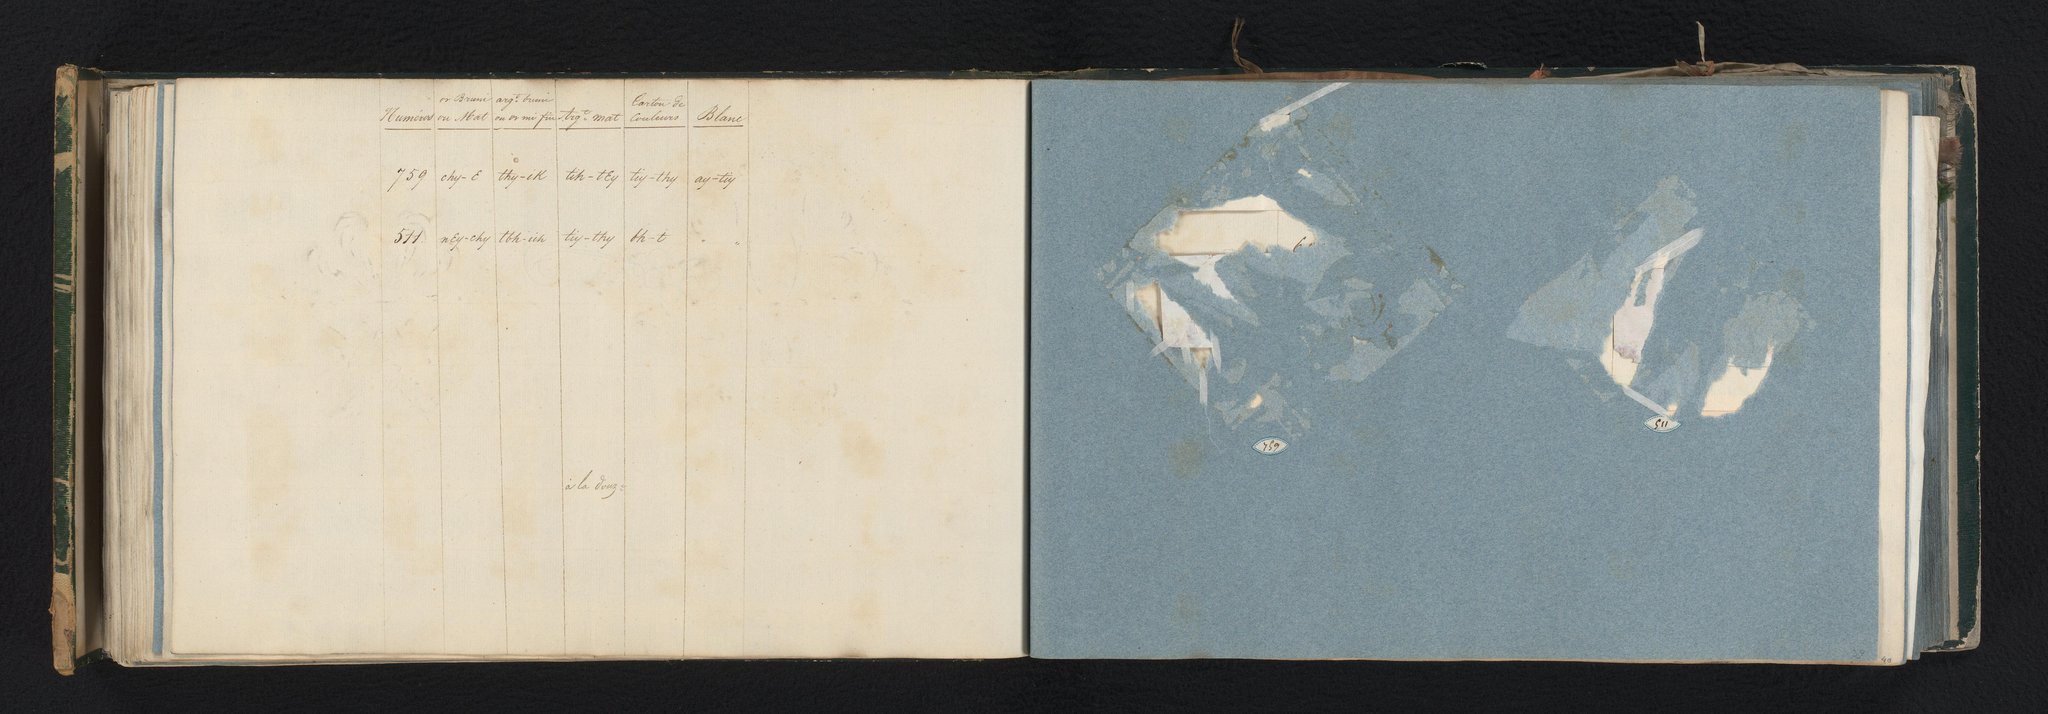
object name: album leaf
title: Twee bladzijden zonder de stalen maar met bijbehorend tabel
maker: Anonymous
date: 1830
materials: ink, paper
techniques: writing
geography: france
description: Twee bladzijden die oorspronkelijk rechts twee opgeplakte en met etiketten genummerde (759-511) ruitvormige stalen van gedecoreerde sierlijsten, waarschijnlijk van goudkleurig metaalpapier, bevatten. Beide stalen ontbreken. Op de tegenoverliggende linkerbladzijde een tabel met de handgeschreven corresponderende specificaties (in code) per ornament. Onderdeel van het stalenboek geschonken door de dames Van Rijn, vermoedelijk van een Franse papierfabrikant van luxe papieren, of diens vertegenwoordiger in Nederland, ca. 1830.